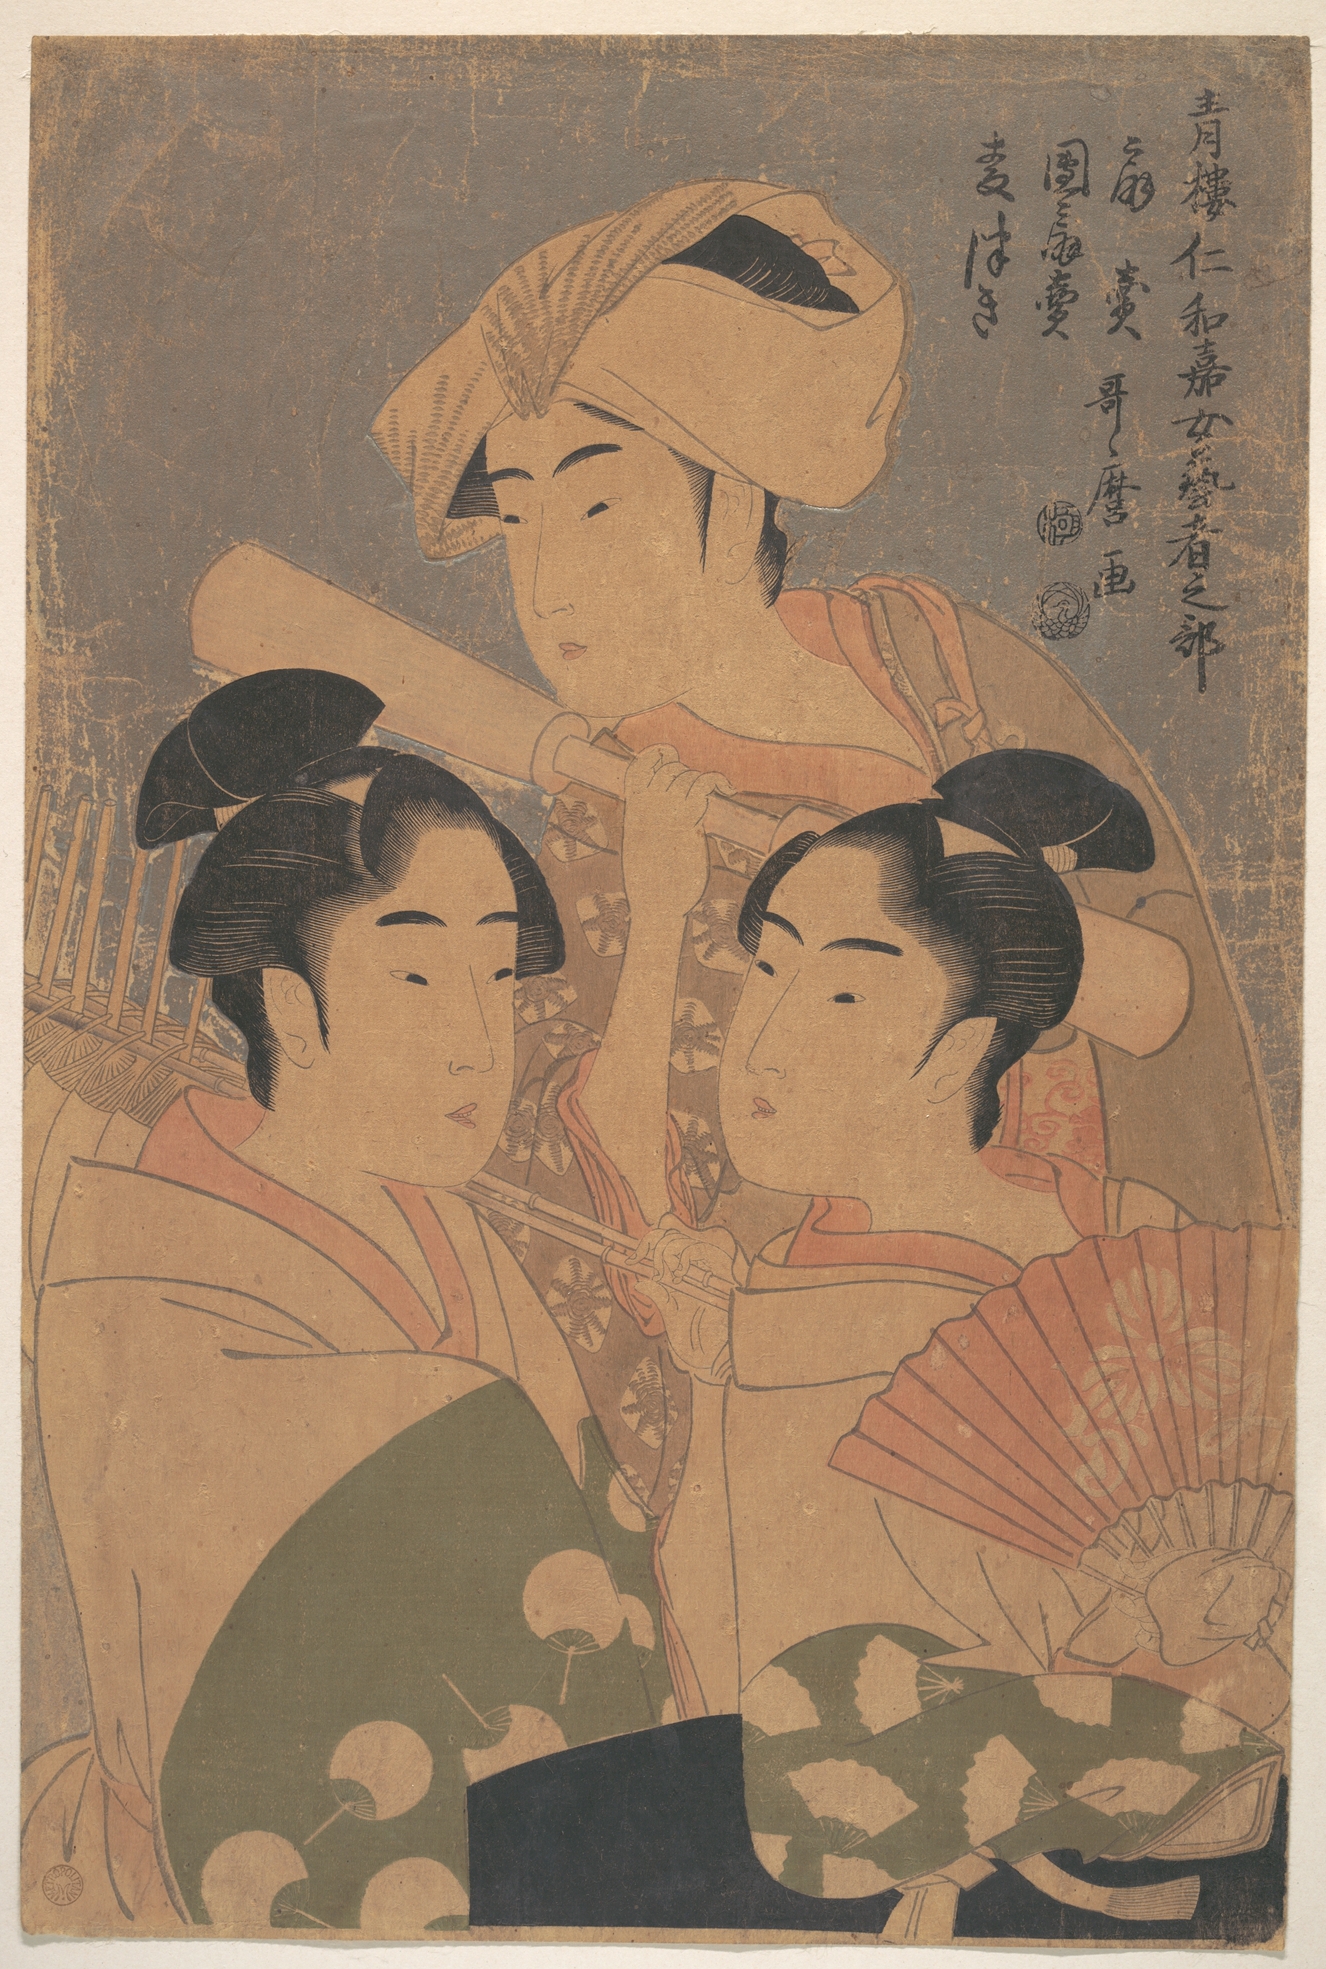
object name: print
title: The Niwaka Performers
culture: japanese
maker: kitagawa utamaro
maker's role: artist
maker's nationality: japanese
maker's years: 1754-1806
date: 1795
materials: ink, paper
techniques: woodblock print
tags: fans,women